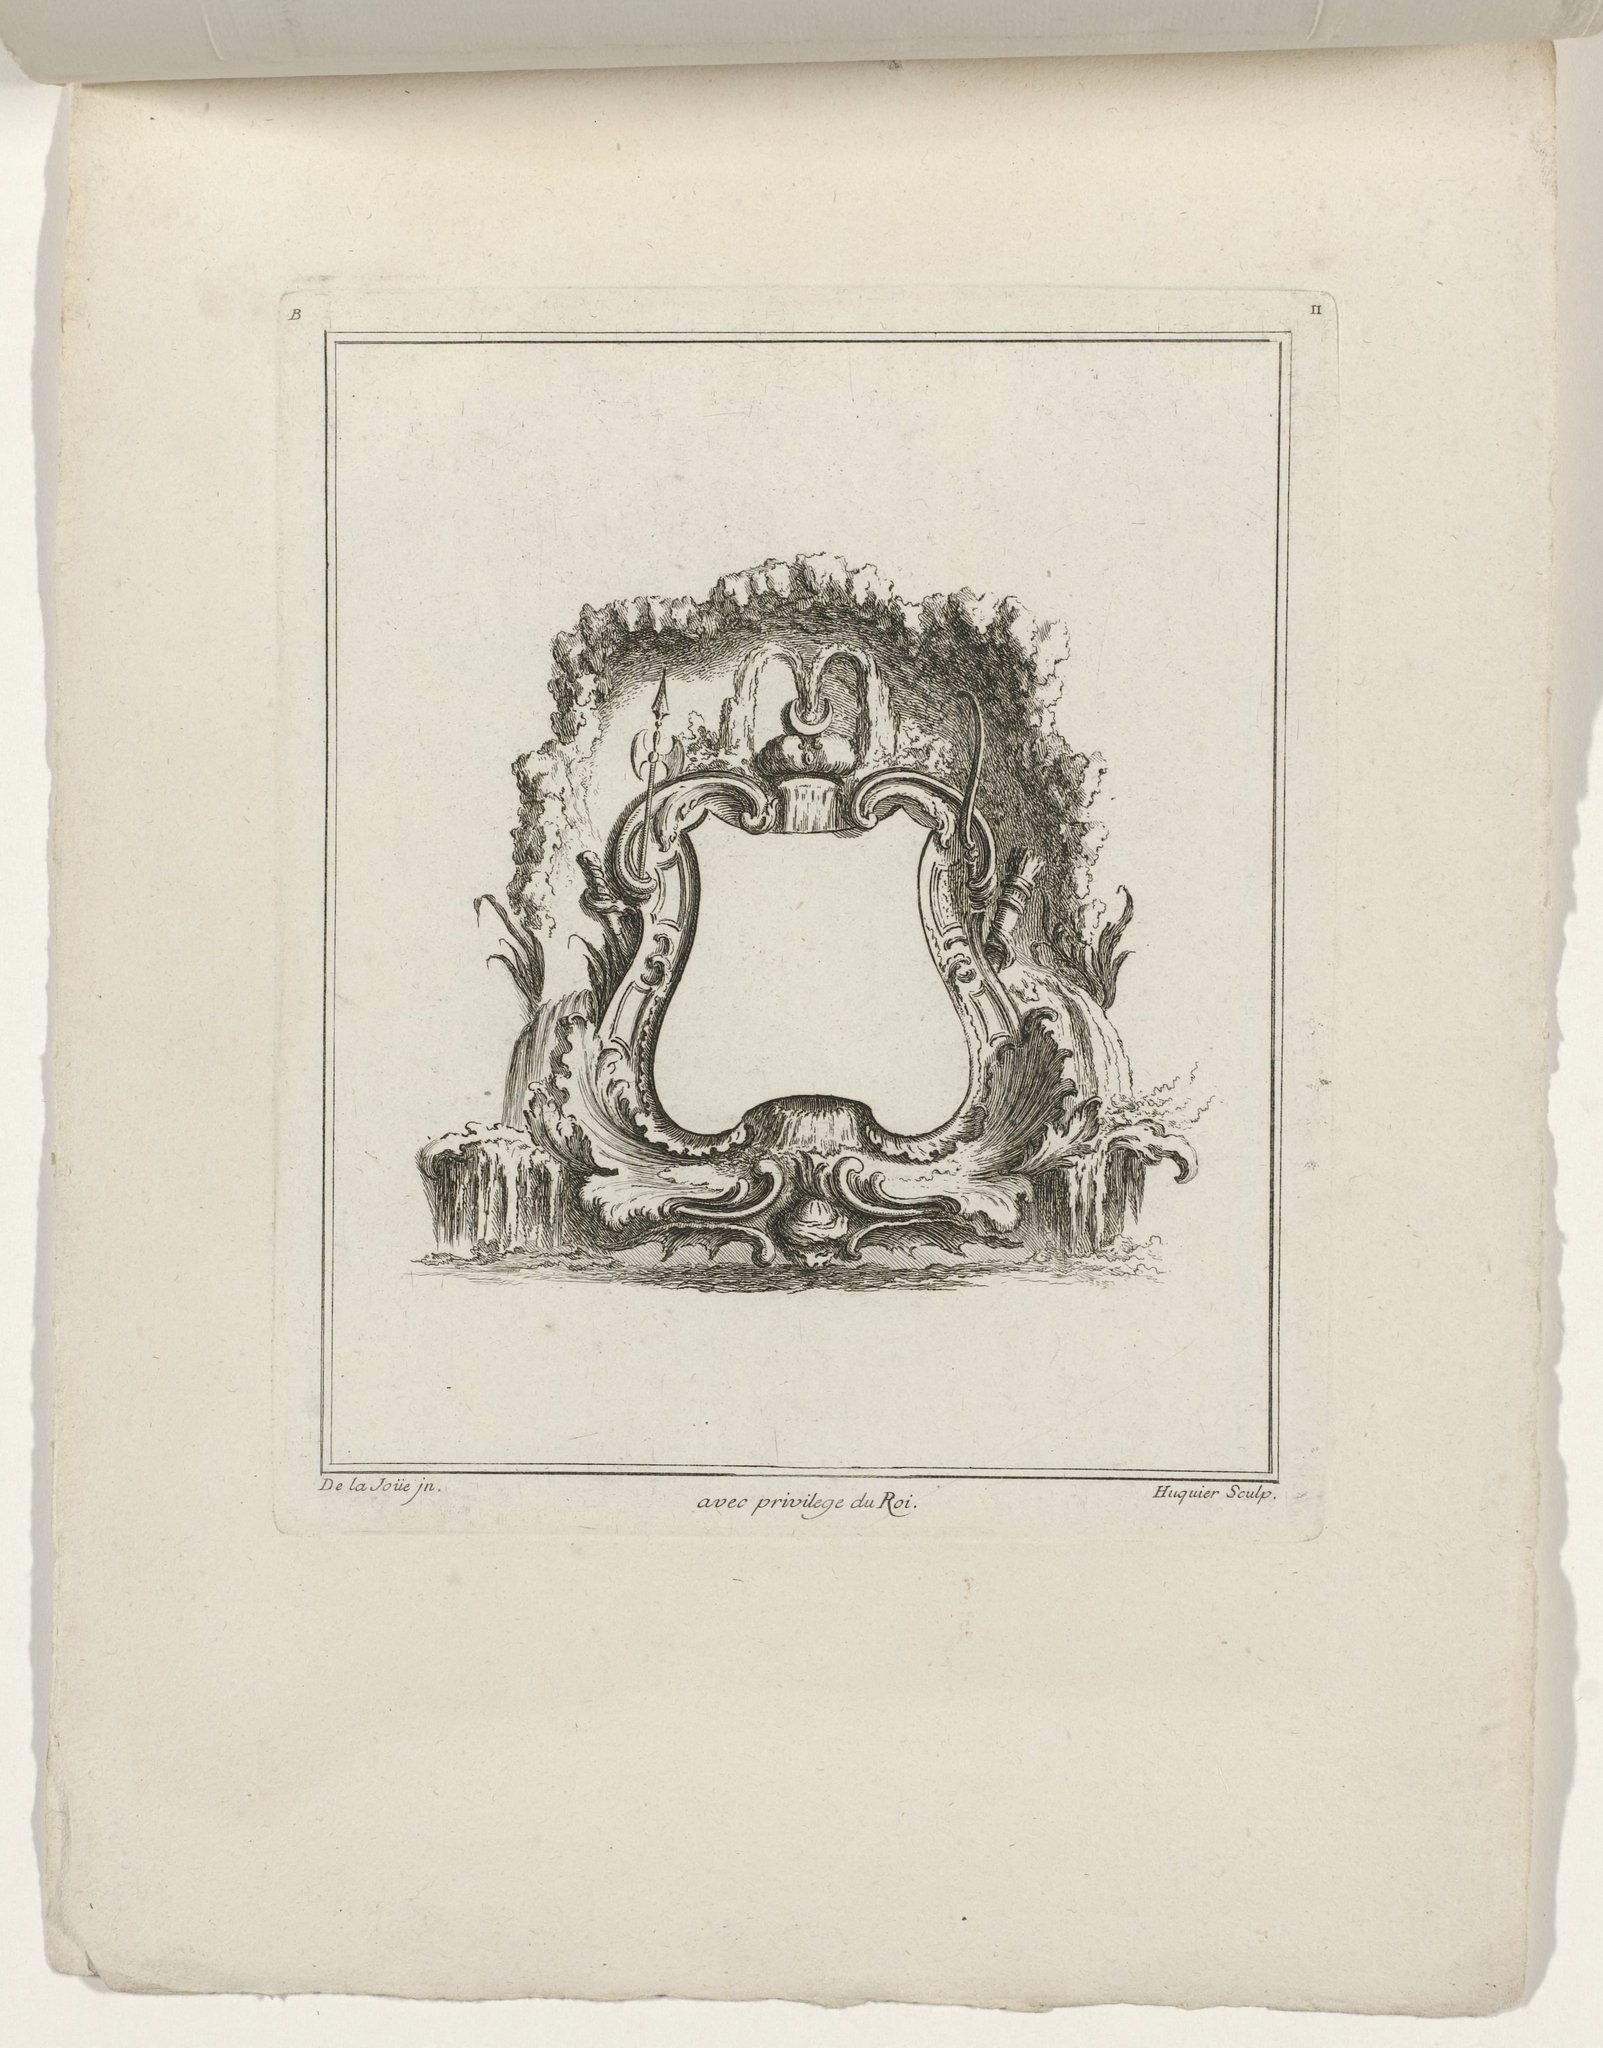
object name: ornament print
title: Cartouche bekroond met een halve maan in een grotto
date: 1710-1772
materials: paper, fiber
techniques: engraving, etching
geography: paris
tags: fantasy ornament, ornament derived from plant forms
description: Cartouche bekroond met een halve maan in een grotto. Onderdeel van een reeks van twaalf genummerde ornamentprenten.